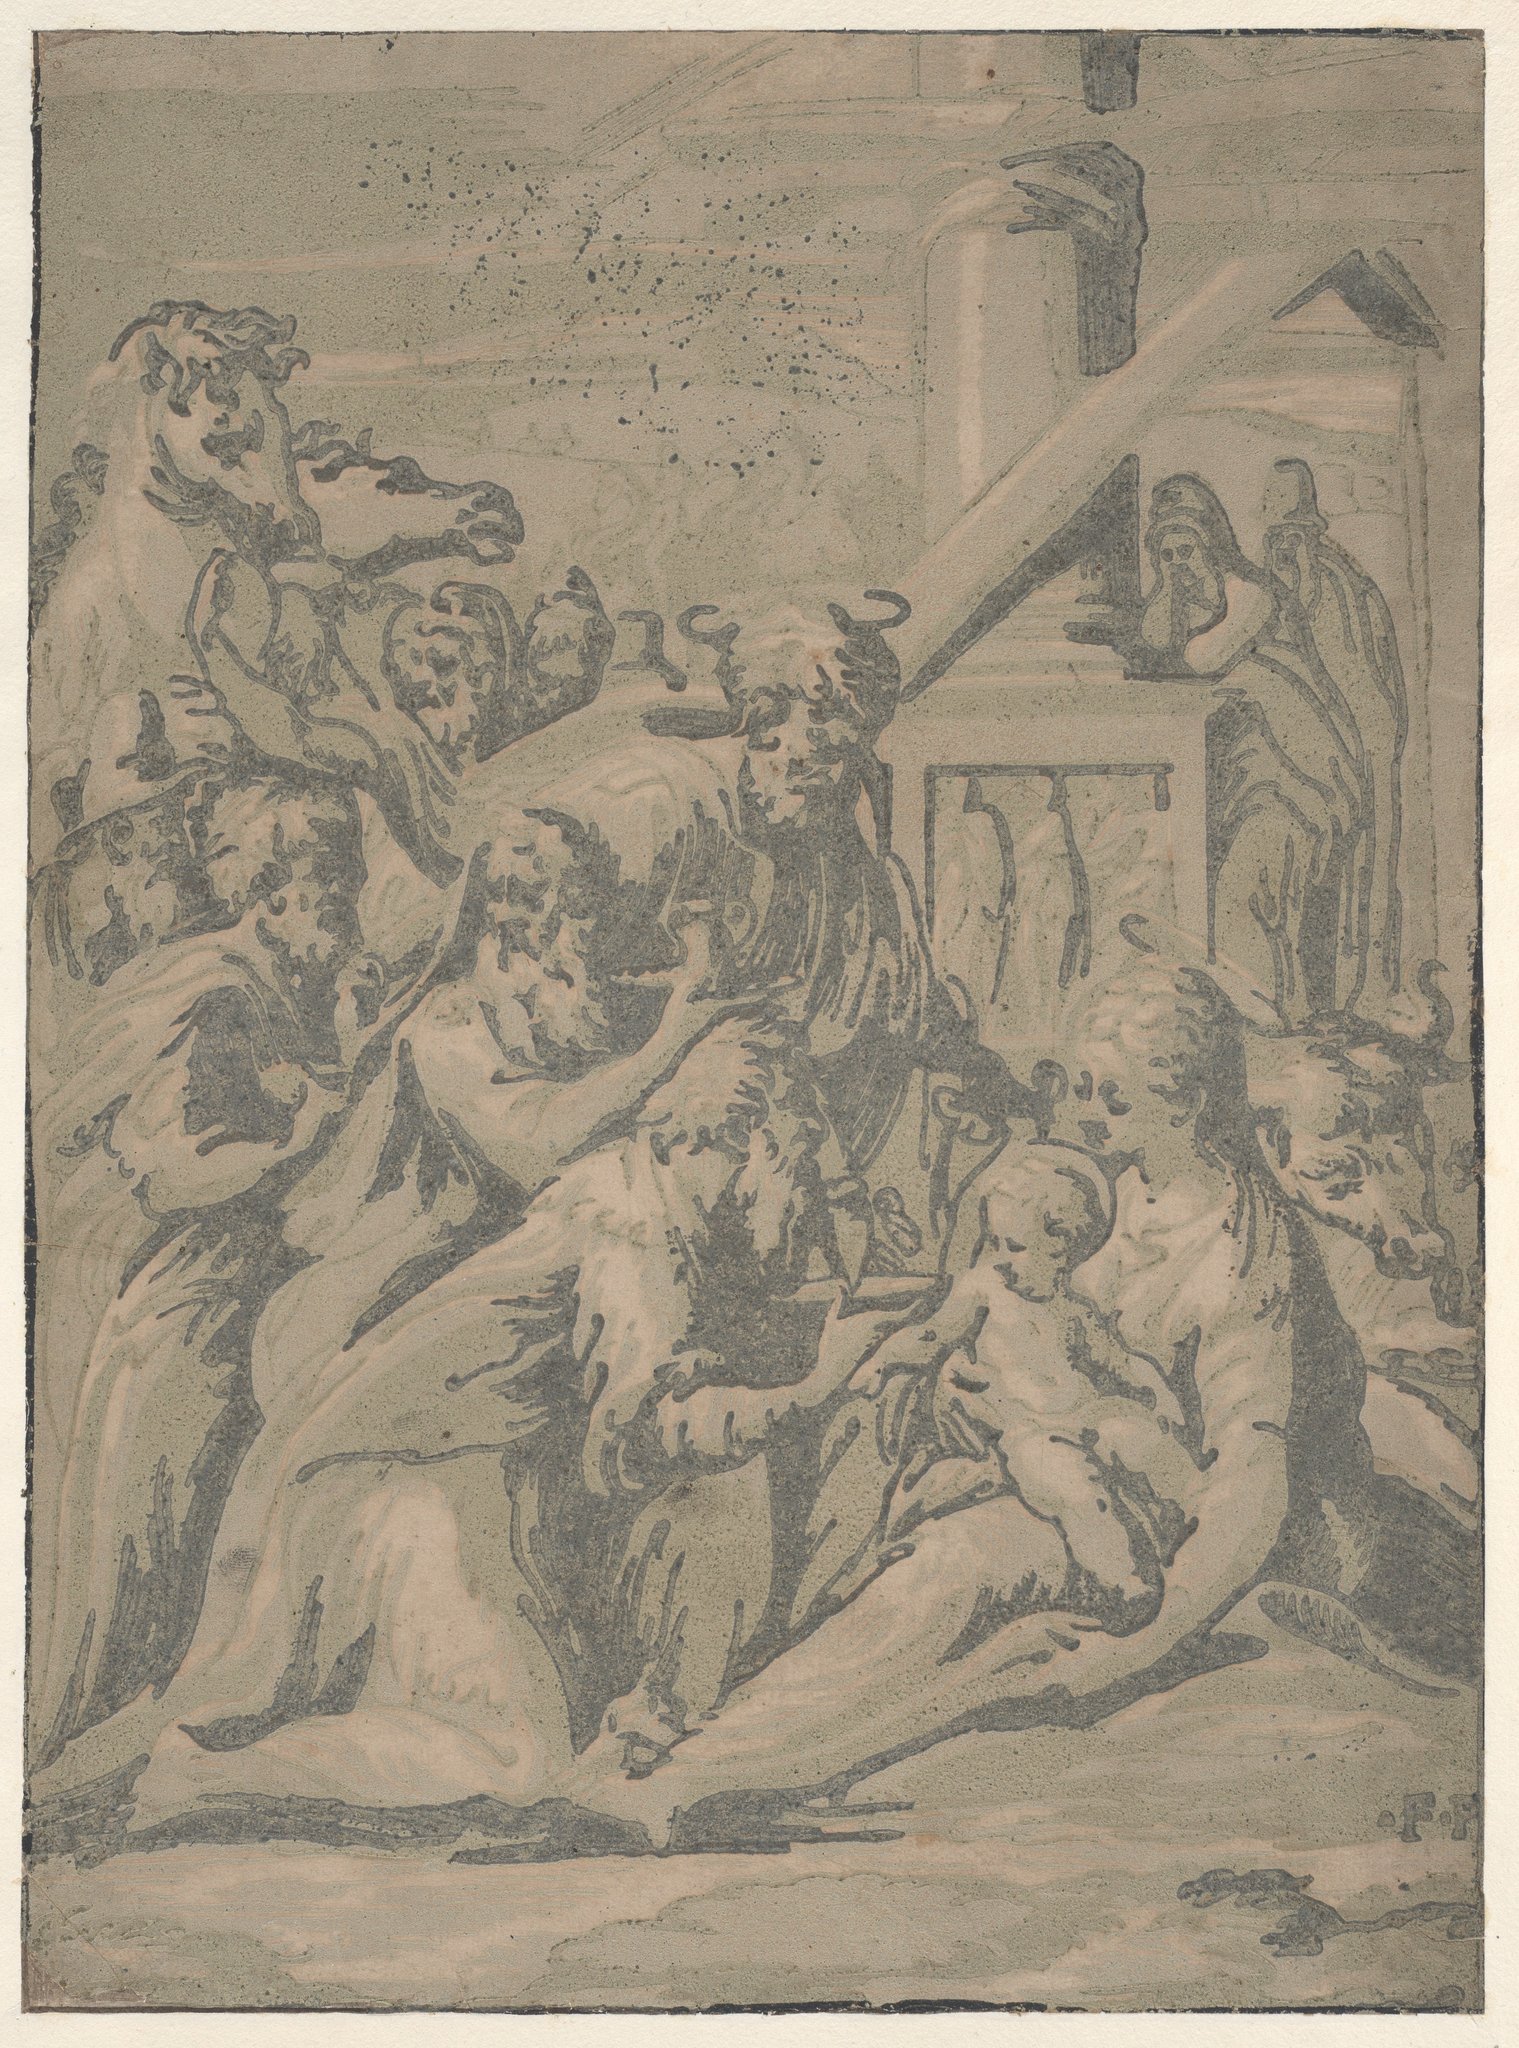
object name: print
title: Adoration of the Magi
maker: niccolò vicentino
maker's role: artist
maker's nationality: italian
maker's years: 1510-1550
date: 1540-1550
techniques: woodcut